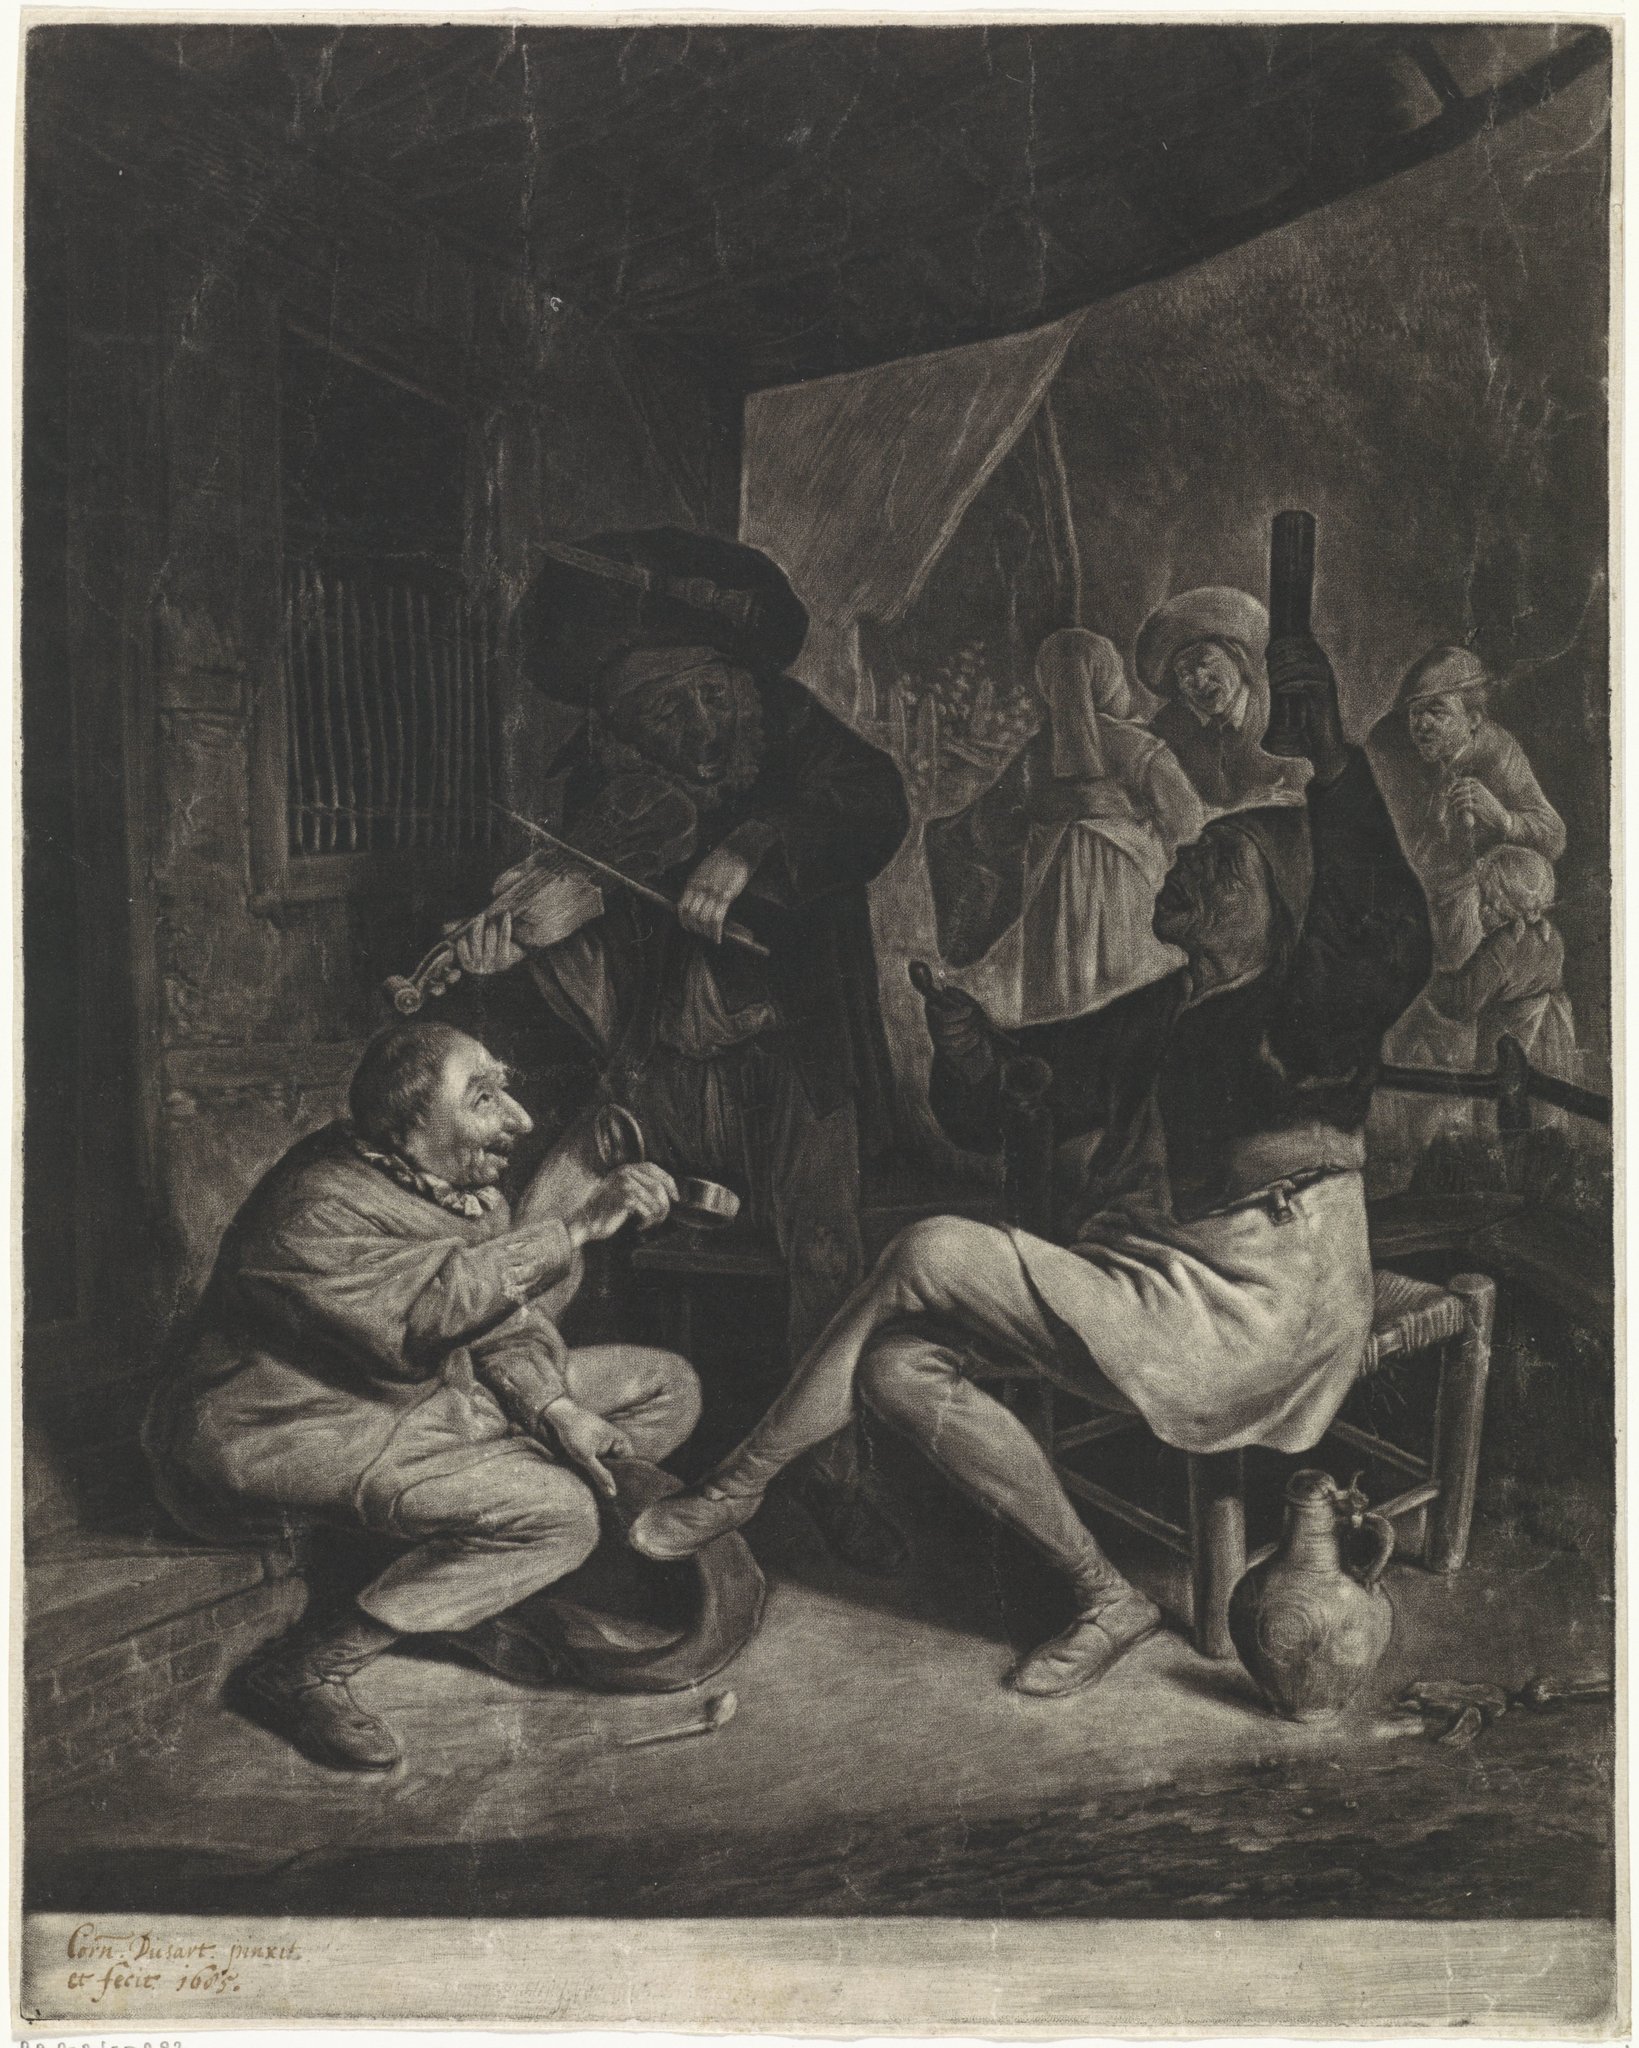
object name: print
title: Musicerende mannen en een man die tabak aanbiedt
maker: cornelis dusart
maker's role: draughtsman, painter, print maker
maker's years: 1660-1704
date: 1685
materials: paper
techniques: mezzotint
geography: haarlem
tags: pipe ~ tobacco, violin, fiddle - cc - out of doors, alcoholic drinks, vocal music, singing - cc - out of doors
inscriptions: collector's mark: Lugt 240, inscription: ‘Corn. Dusart. pinxit / et fecit 1685’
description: Onder de luifel van een huis speelt een zingende man viool. Een andere man heft zijn glas en zingt mee, en een derde biedt tabak aan. Op de achtergrond voeren enkele figuren een gesprek.